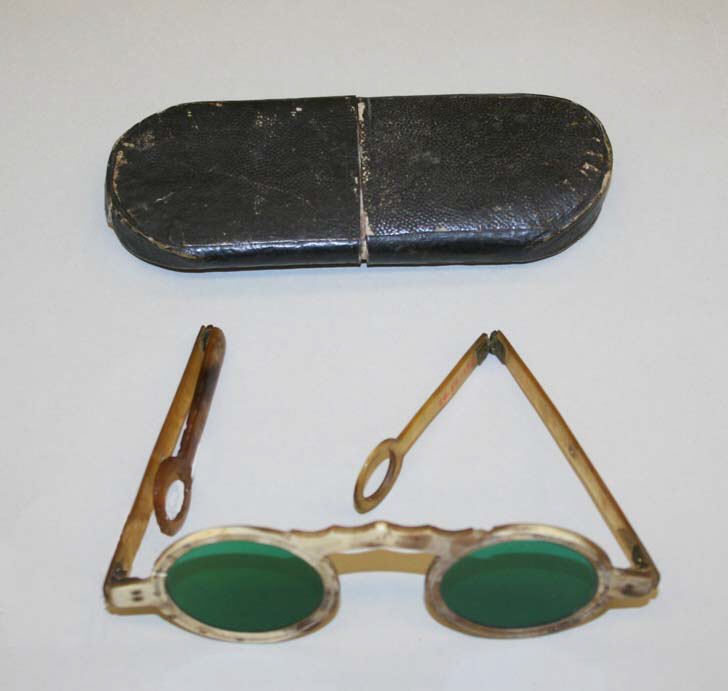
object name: spectacle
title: Spectacles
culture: italian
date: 1801-1900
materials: horn, leather